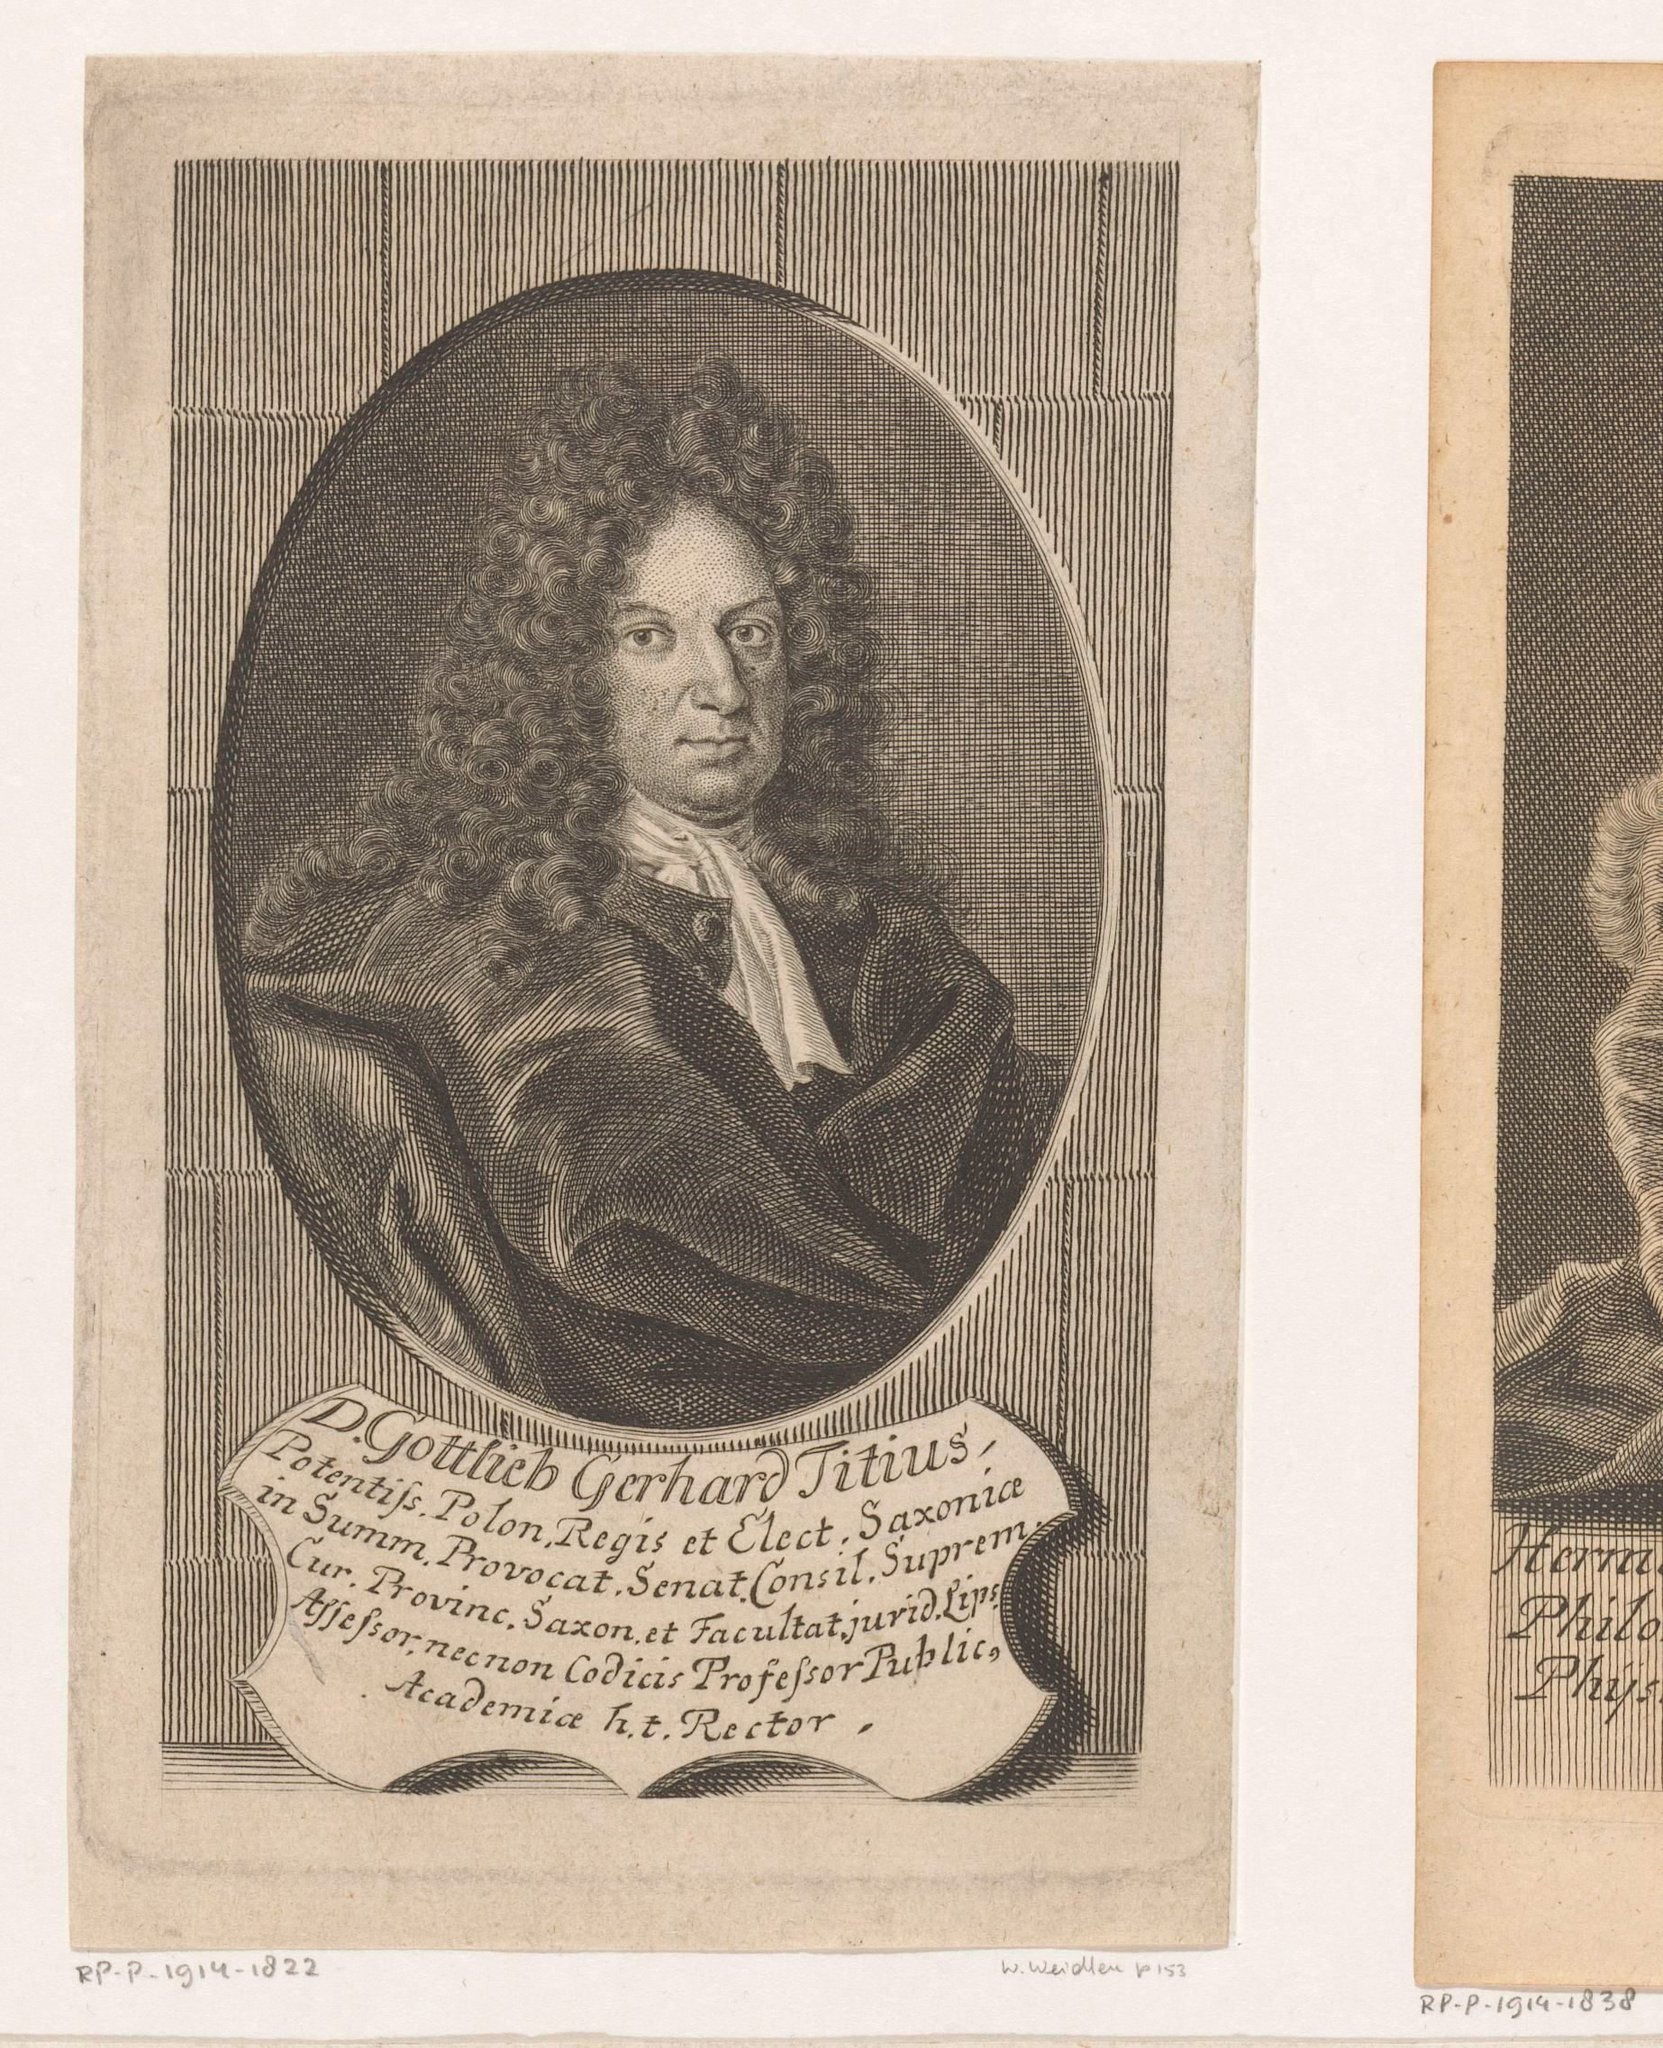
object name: print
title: Portret van Gottlieb Gerhard Titius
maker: martin bernigeroth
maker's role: print maker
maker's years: 1670-1733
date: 1713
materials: paper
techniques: engraving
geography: leipzig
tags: historical persons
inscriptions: collector's mark: Lugt 2228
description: Prent ook gebruikt in: Deutsche Acta Eruditorum (...). dl. 123. Leipzig: Johann Gottlieb Gleditsch, 1713.